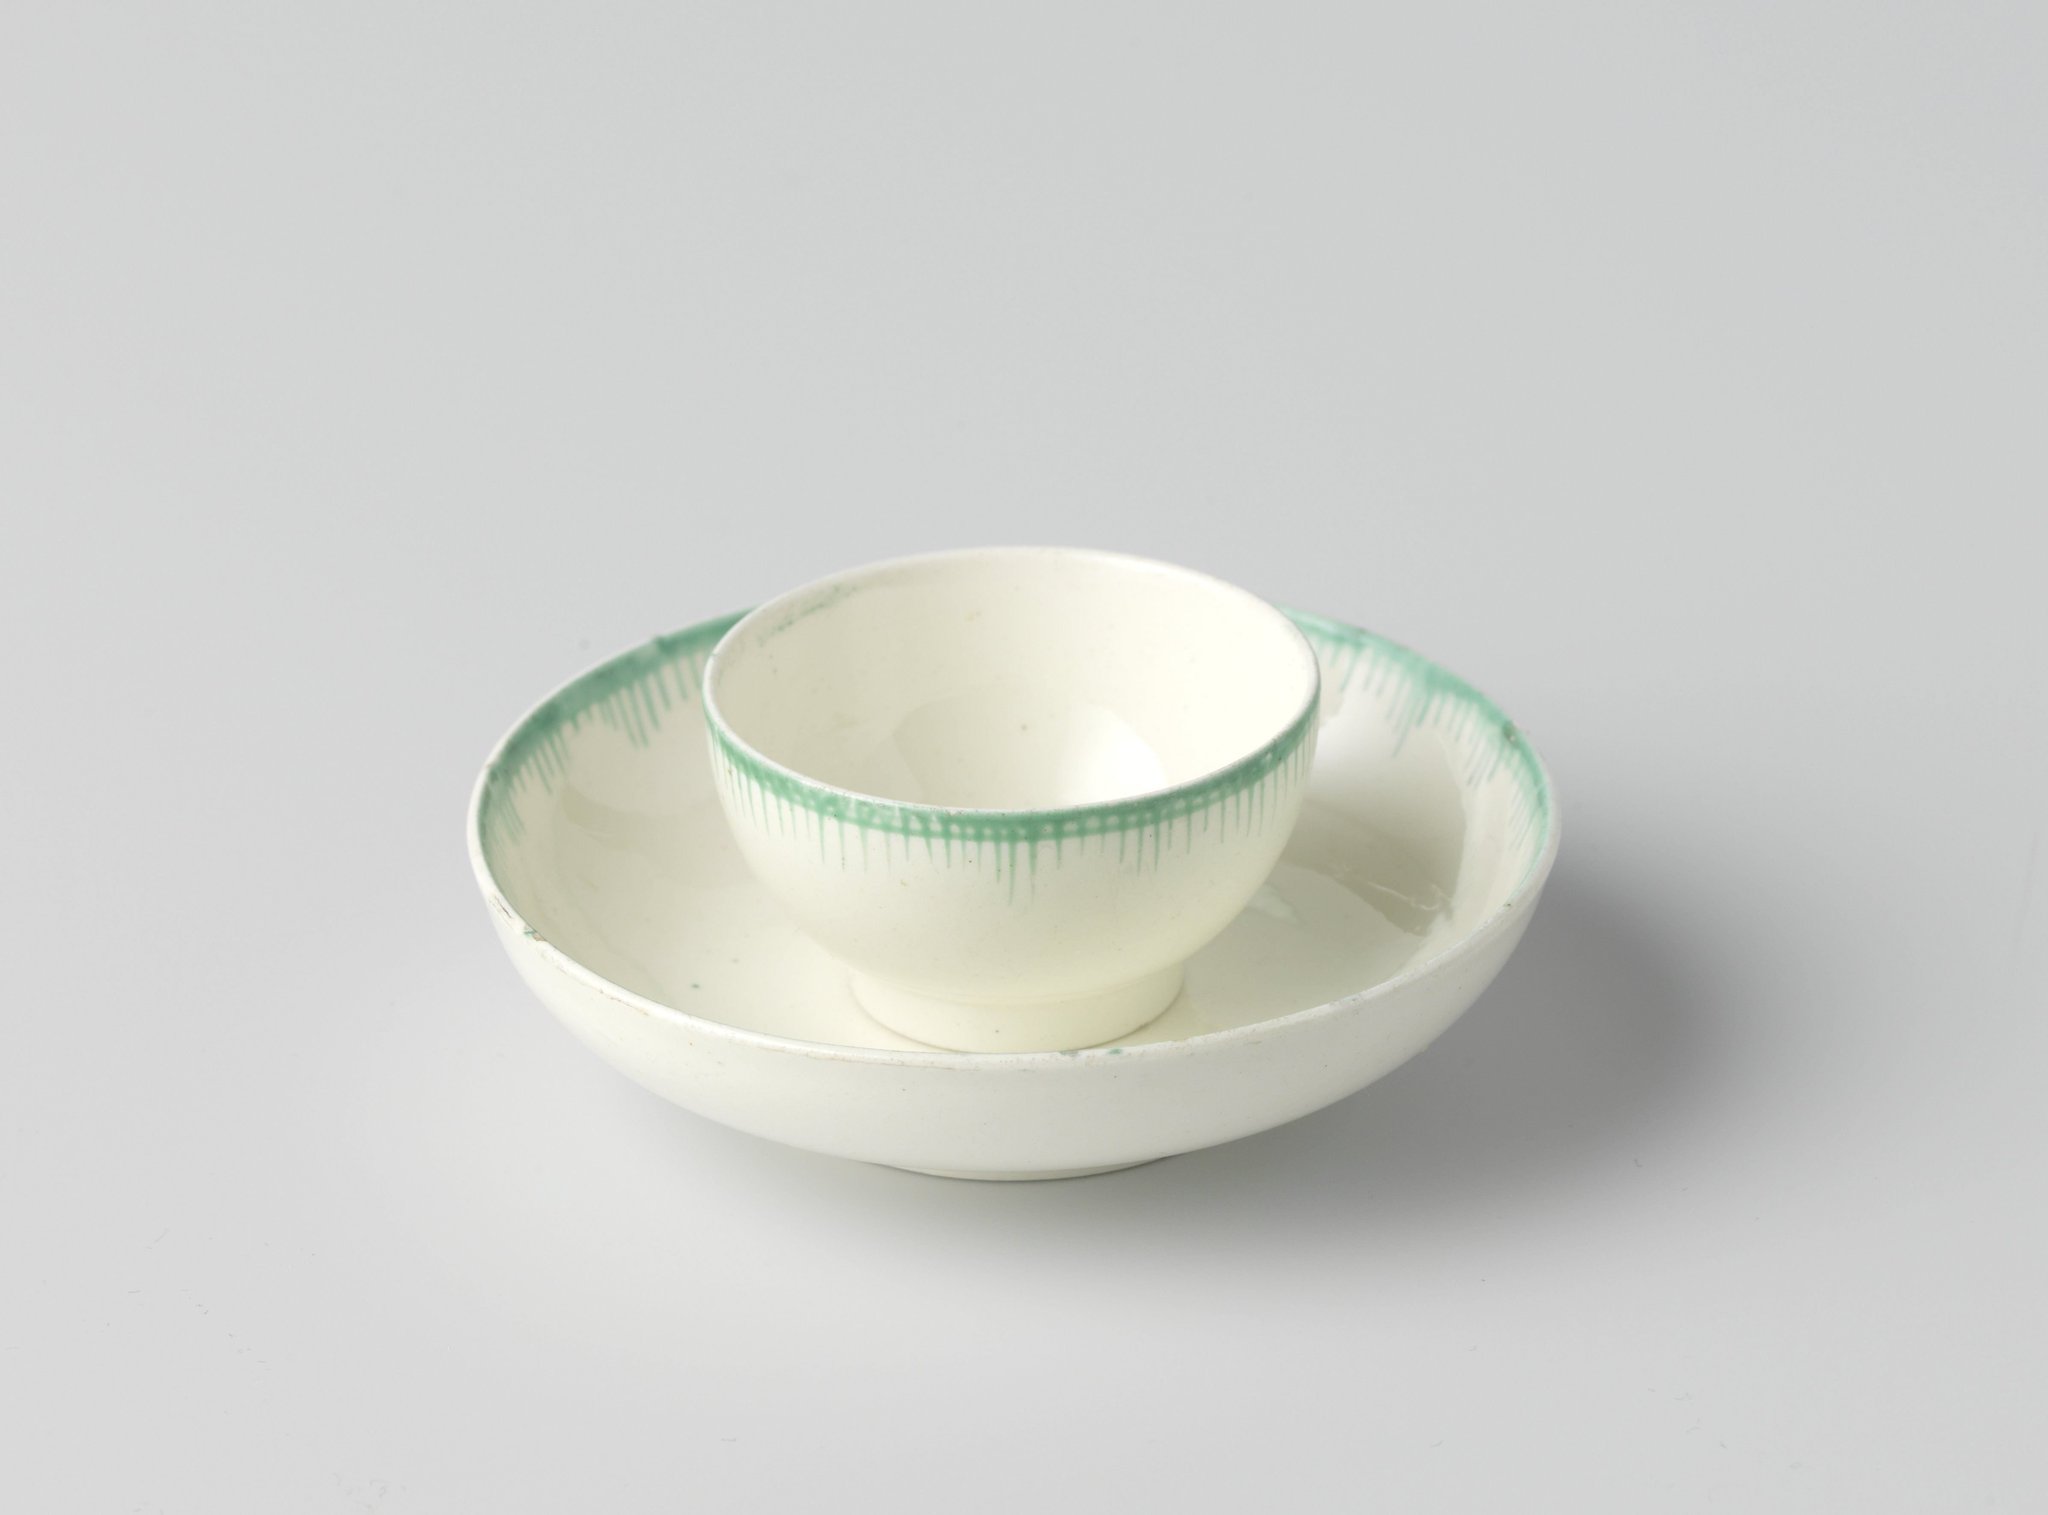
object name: kop en schotel, kop en schotel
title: Kop en schotel van hardgebakken aardewerk, creamware.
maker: Anonymous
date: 1790-1810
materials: earthenware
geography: england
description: Kop en schotel van hardgebakken aardewerk, van een kinderservies. Kop en schotel hebben beide een groene uitstralende rand. De kop en schotel horen bij drie kop en schotels (BK-NM-11012-A t/m BK-NM-11012-D. Bij de kop en schotels hoort een theebus met invnr. BK-NM-11013.